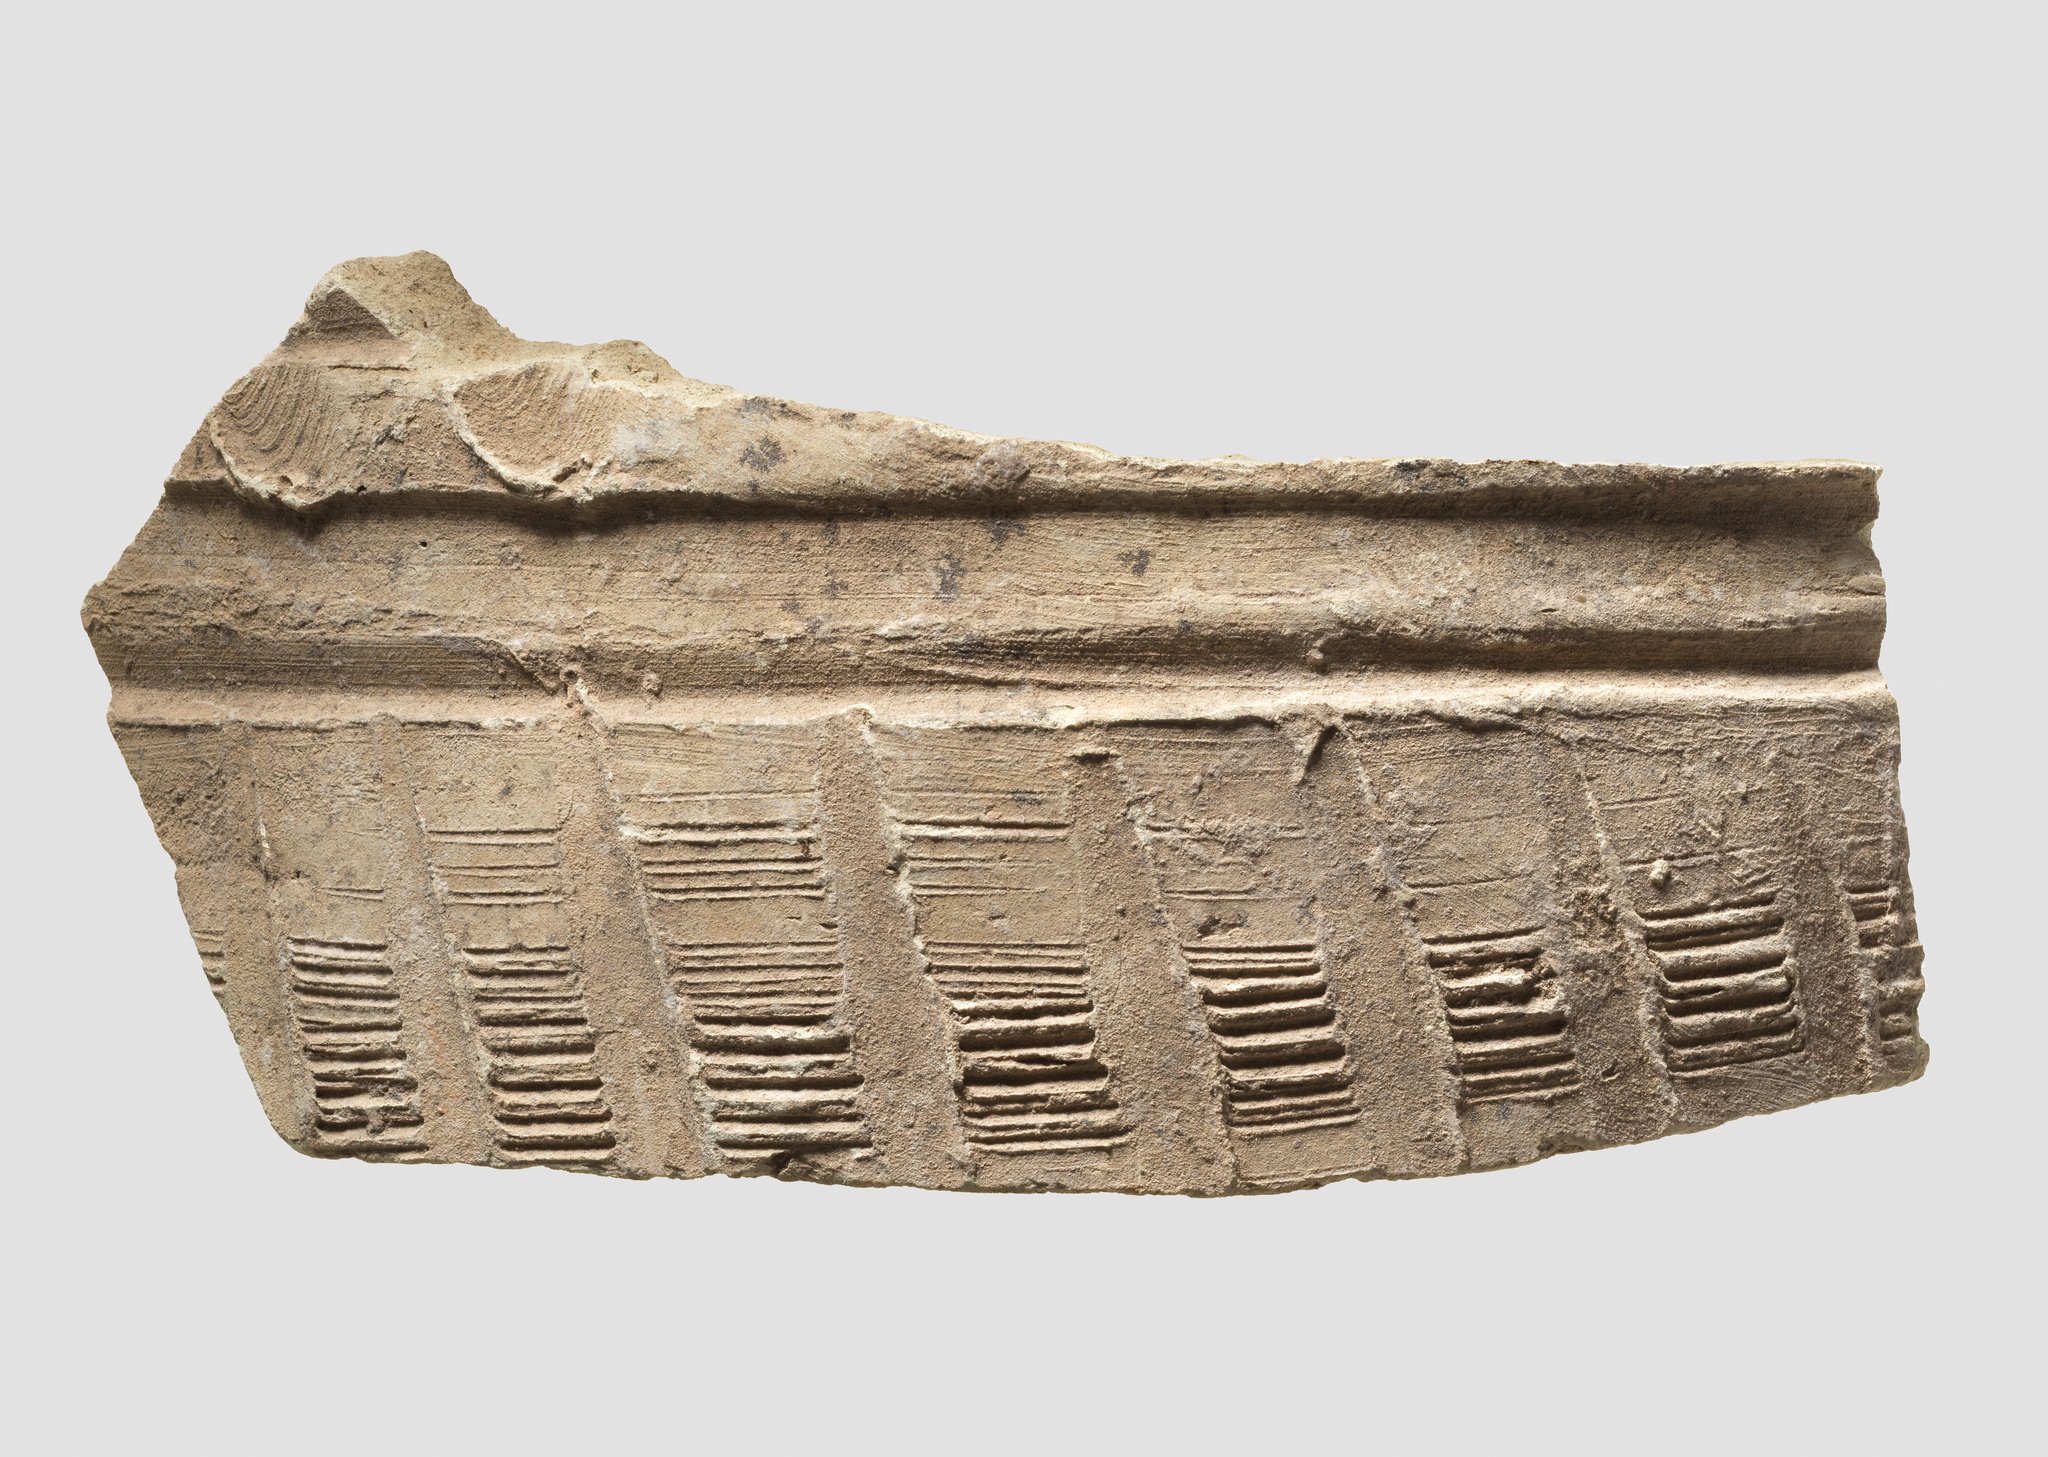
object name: sherd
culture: sasanian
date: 201-700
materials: ceramic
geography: mesopotamia